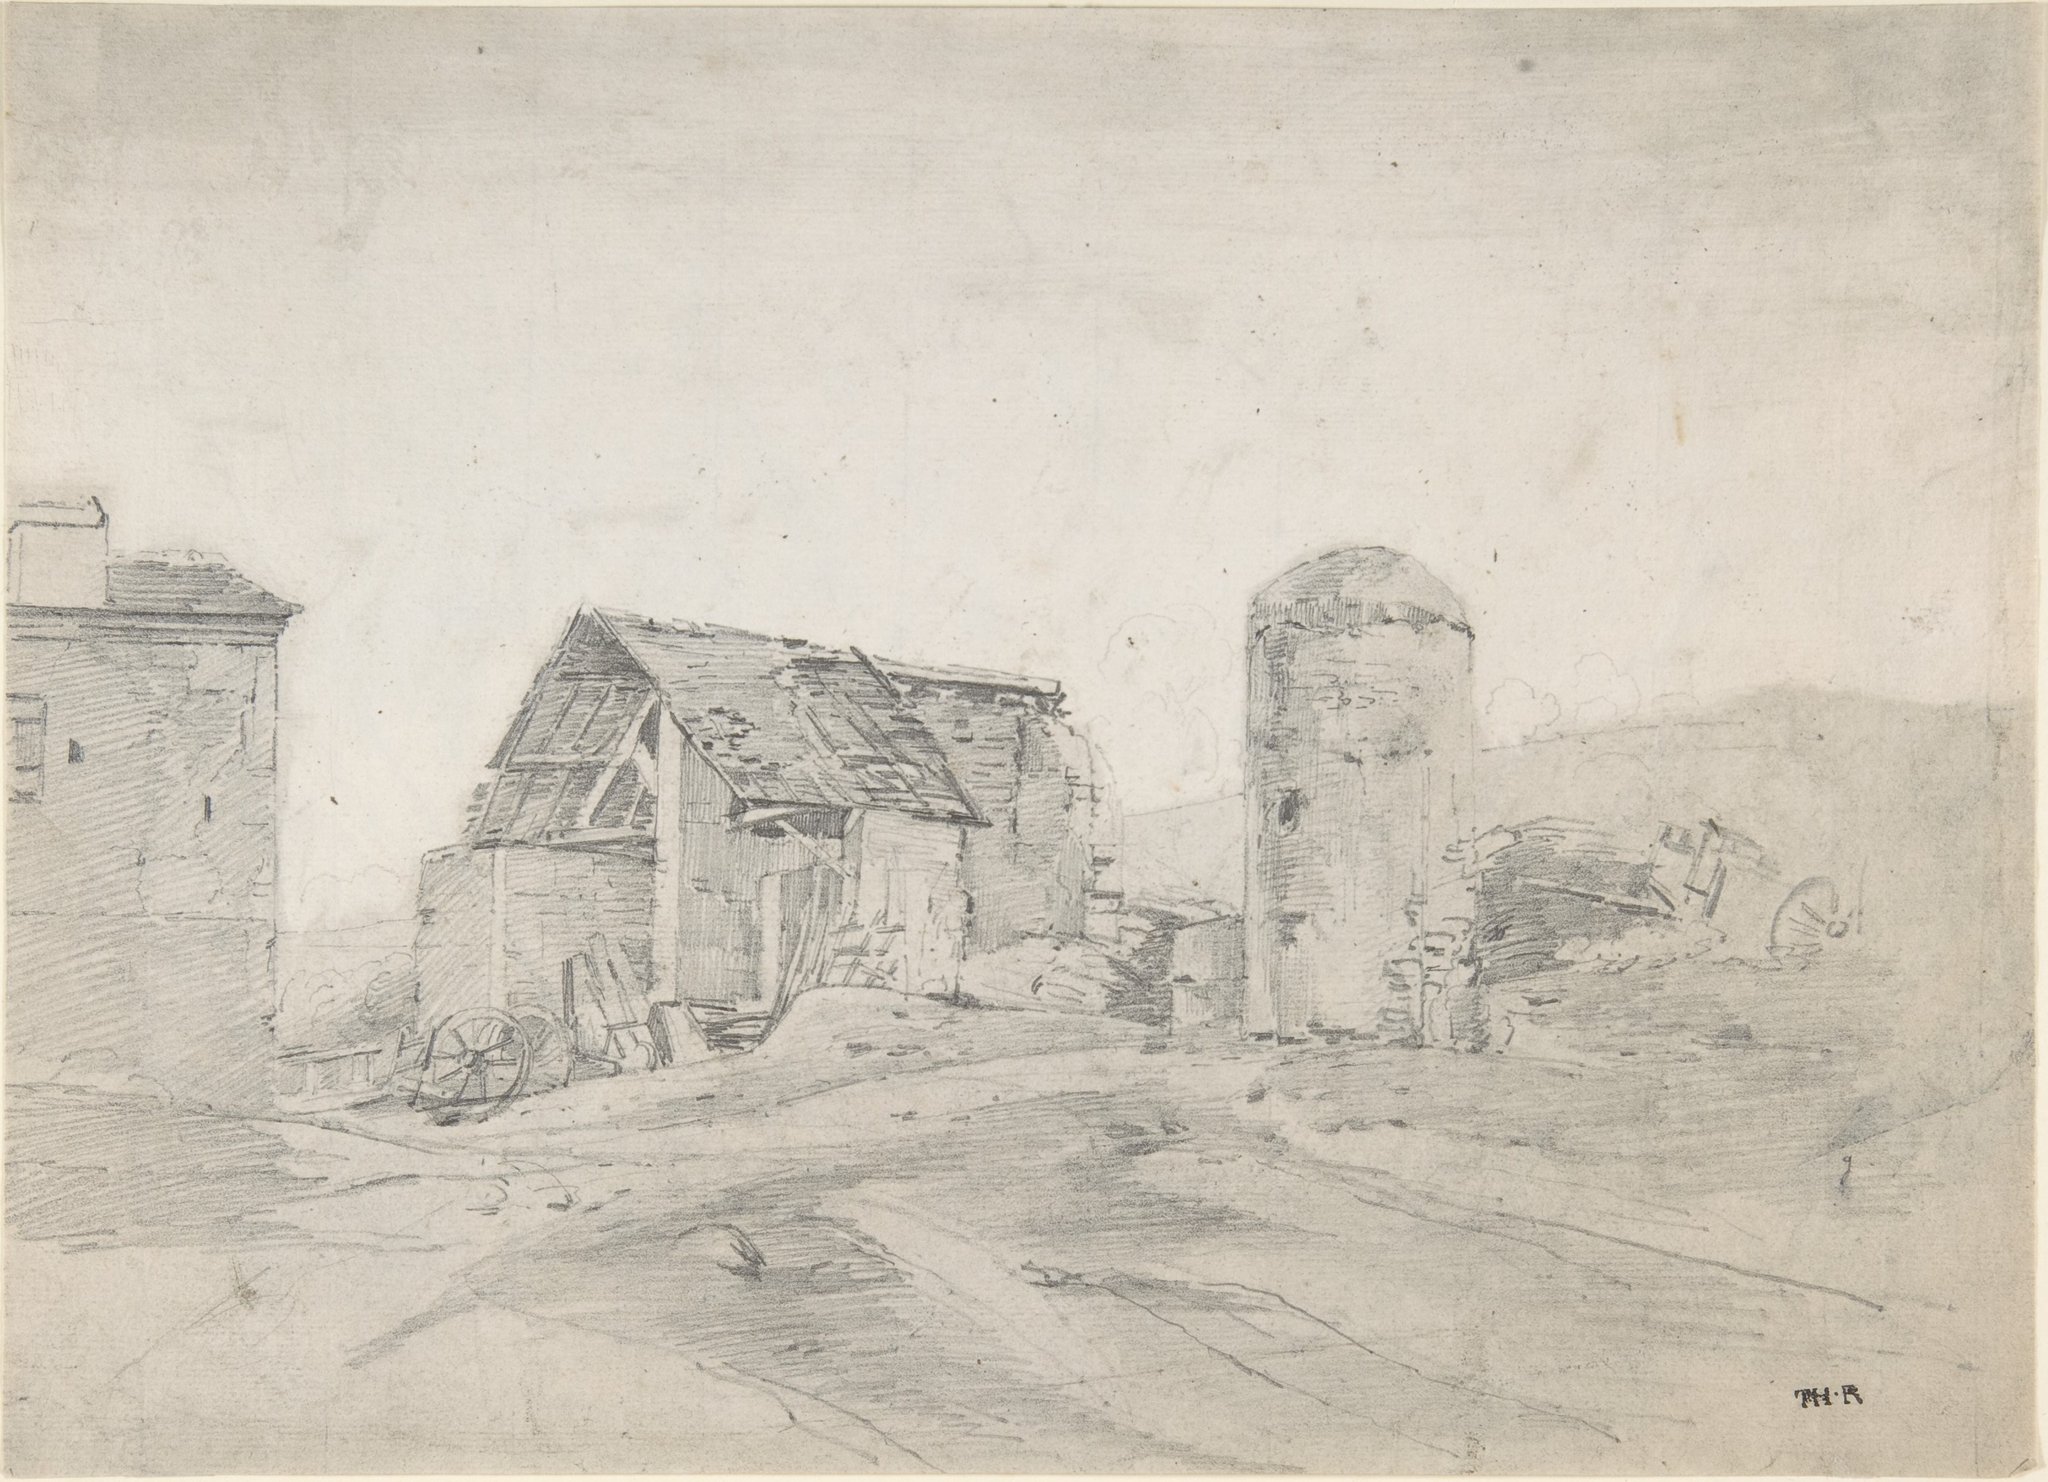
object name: drawing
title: Farmyard in Normandy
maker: théodore rousseau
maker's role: artist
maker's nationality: french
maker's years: 1812-1867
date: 1831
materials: graphite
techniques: wash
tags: houses,farms